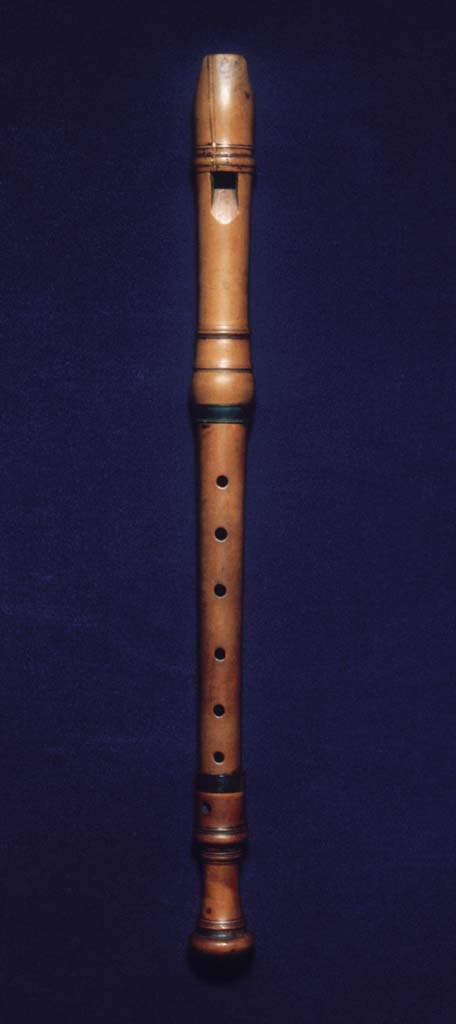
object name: alto recorder in f sharp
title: Alto Recorder in F-sharp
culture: german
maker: johann wilhelm oberlender (the elder)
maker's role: maker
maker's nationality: german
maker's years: 1681-1763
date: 1734-1766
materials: horn, wood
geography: germany